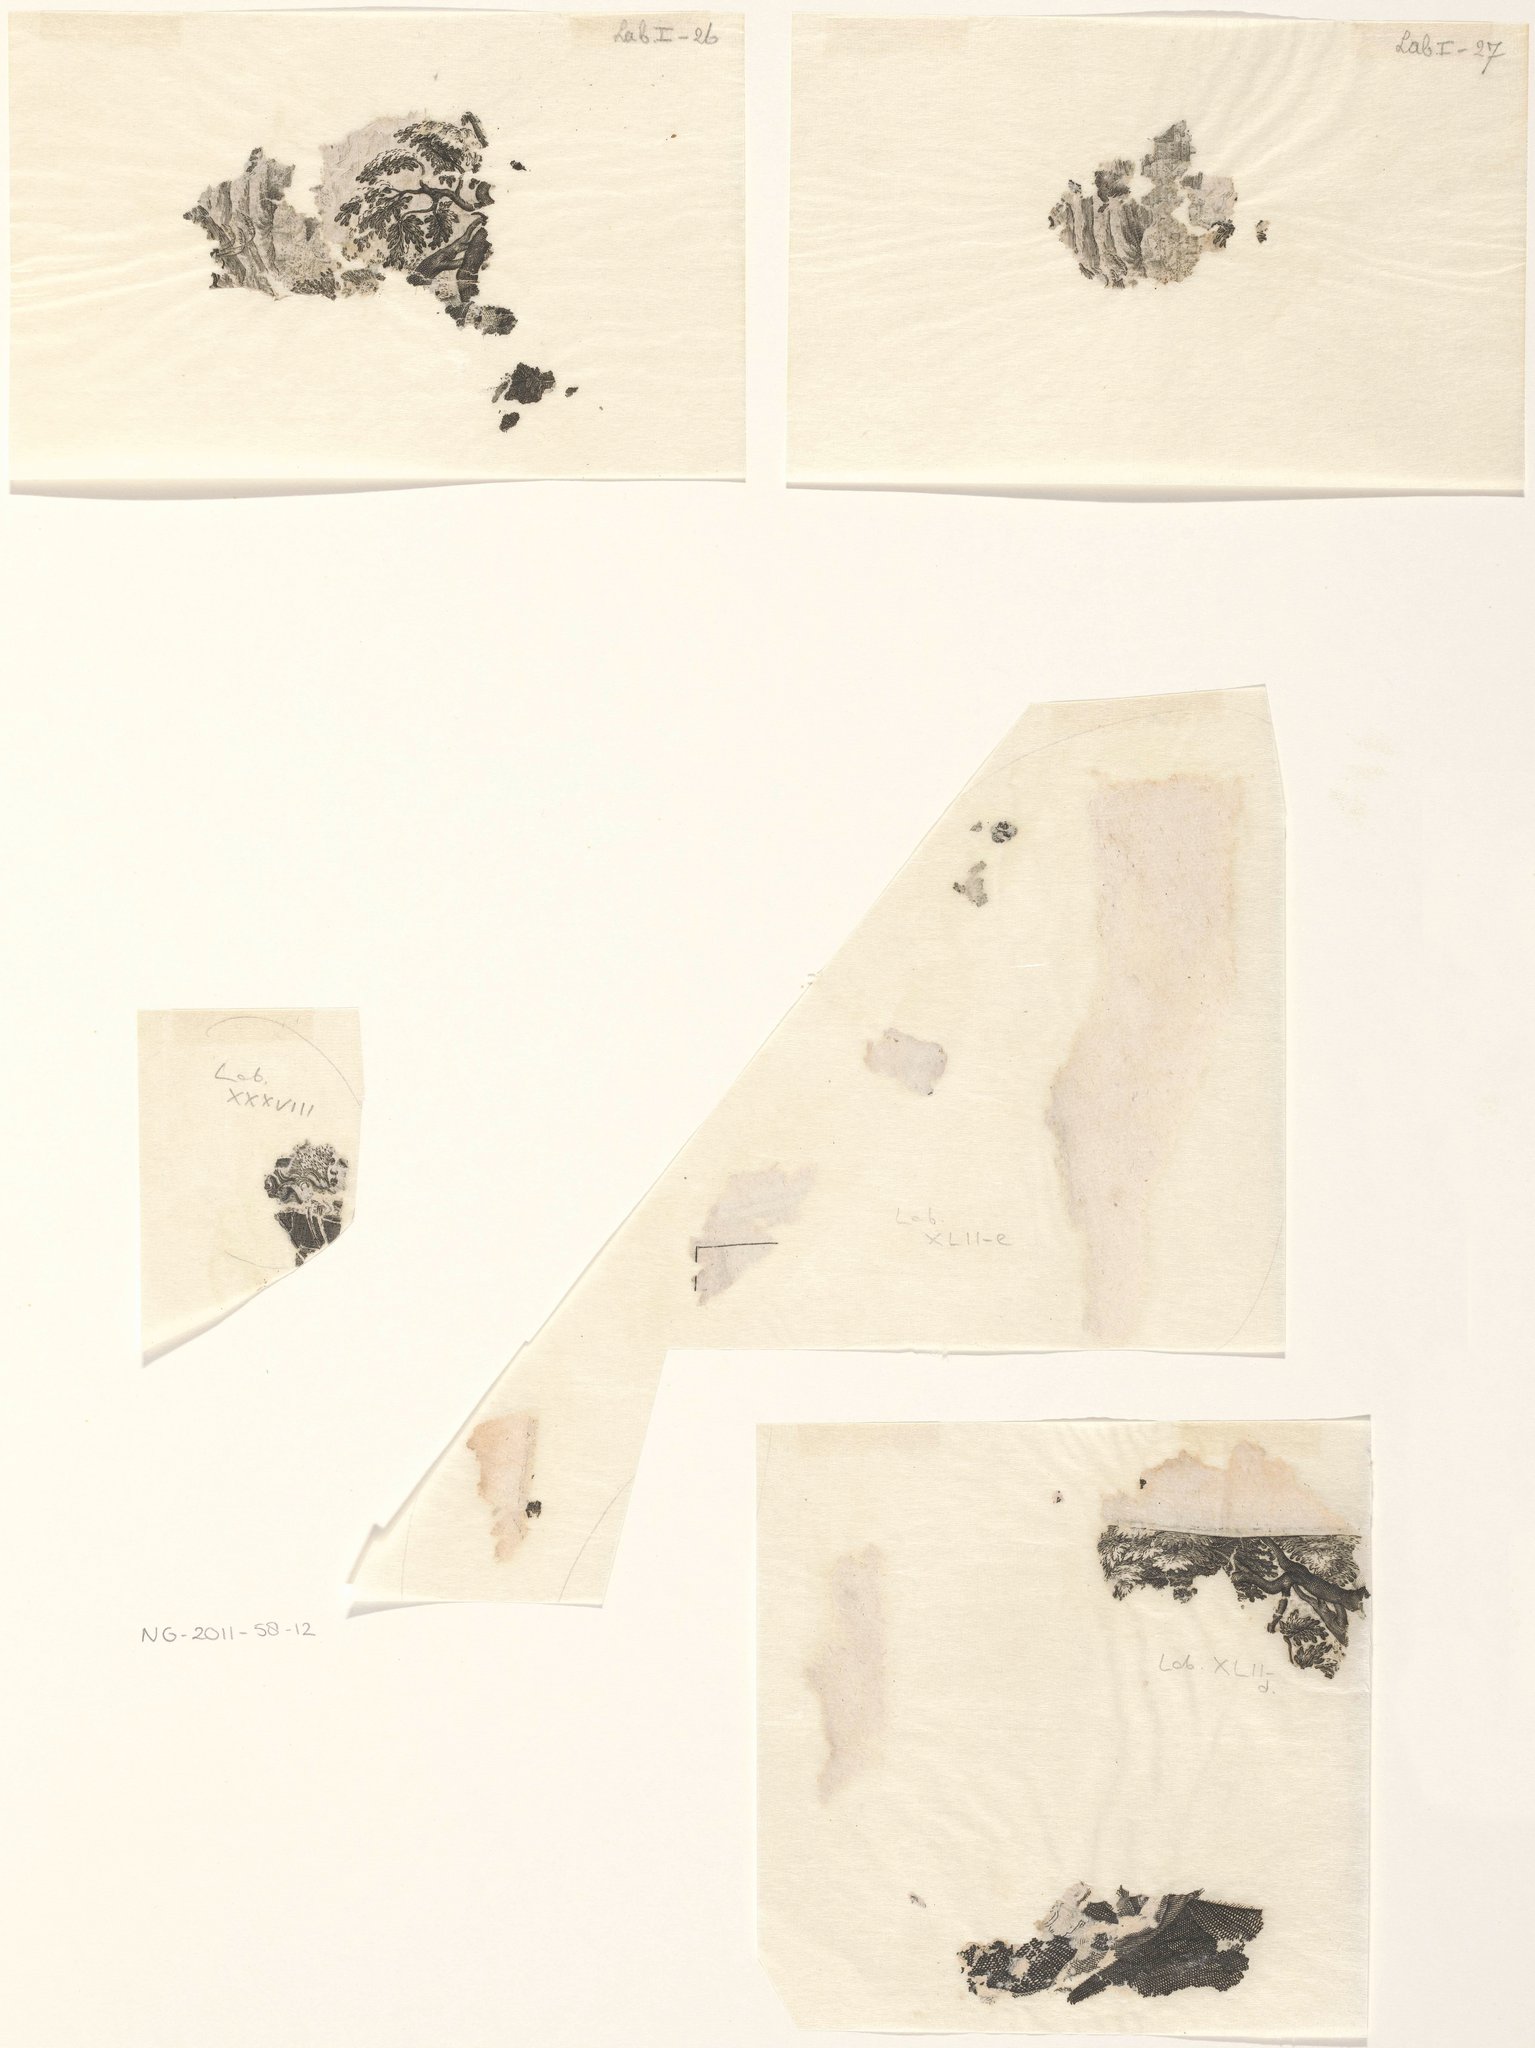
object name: print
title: Losse fragmenten van een prent van Pyramus en Thisbe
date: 1580-1596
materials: paper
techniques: engraving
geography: northern netherlands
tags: thisbe kills herself with pyramus' sword (the scene may be represented near a fountain)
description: De prenten in de Nova Zembla collectie zijn tijdens een expeditie van Willem Barendsz en Jacob van Heemskerk in 1596-1597 noodgedwongen in het winterkamp, het ‘Behouden Huis’, op het eiland achtergelaten. De prenten waren in één of meerdere stapels als handelswaar meegenomen vanuit Amsterdam. Bijna drie eeuwen later, in 1871, keerde de Noor Elling Carlsen terug naar Nova Zembla en vond daar de restanten van het ‘Behouden Huis, inclusief een groot deel van de inventaris. Een deel van de prenten, in de vorm van aaneengekoekte kluiten, werd toen ook teruggevonden. De papierkluiten waren soms op meerdere plekken gebroken. Tussen 1975-1979 zijn de prenten van elkaar gescheiden. Dit leverde in totaal ca. 1000 fragmenten van ca. 400 afdrukken van ca. 150 verschillende prenten op. Voor zover mogelijk zijn de fragmenten samengevoegd en zijn de prenten gereconstrueerd.